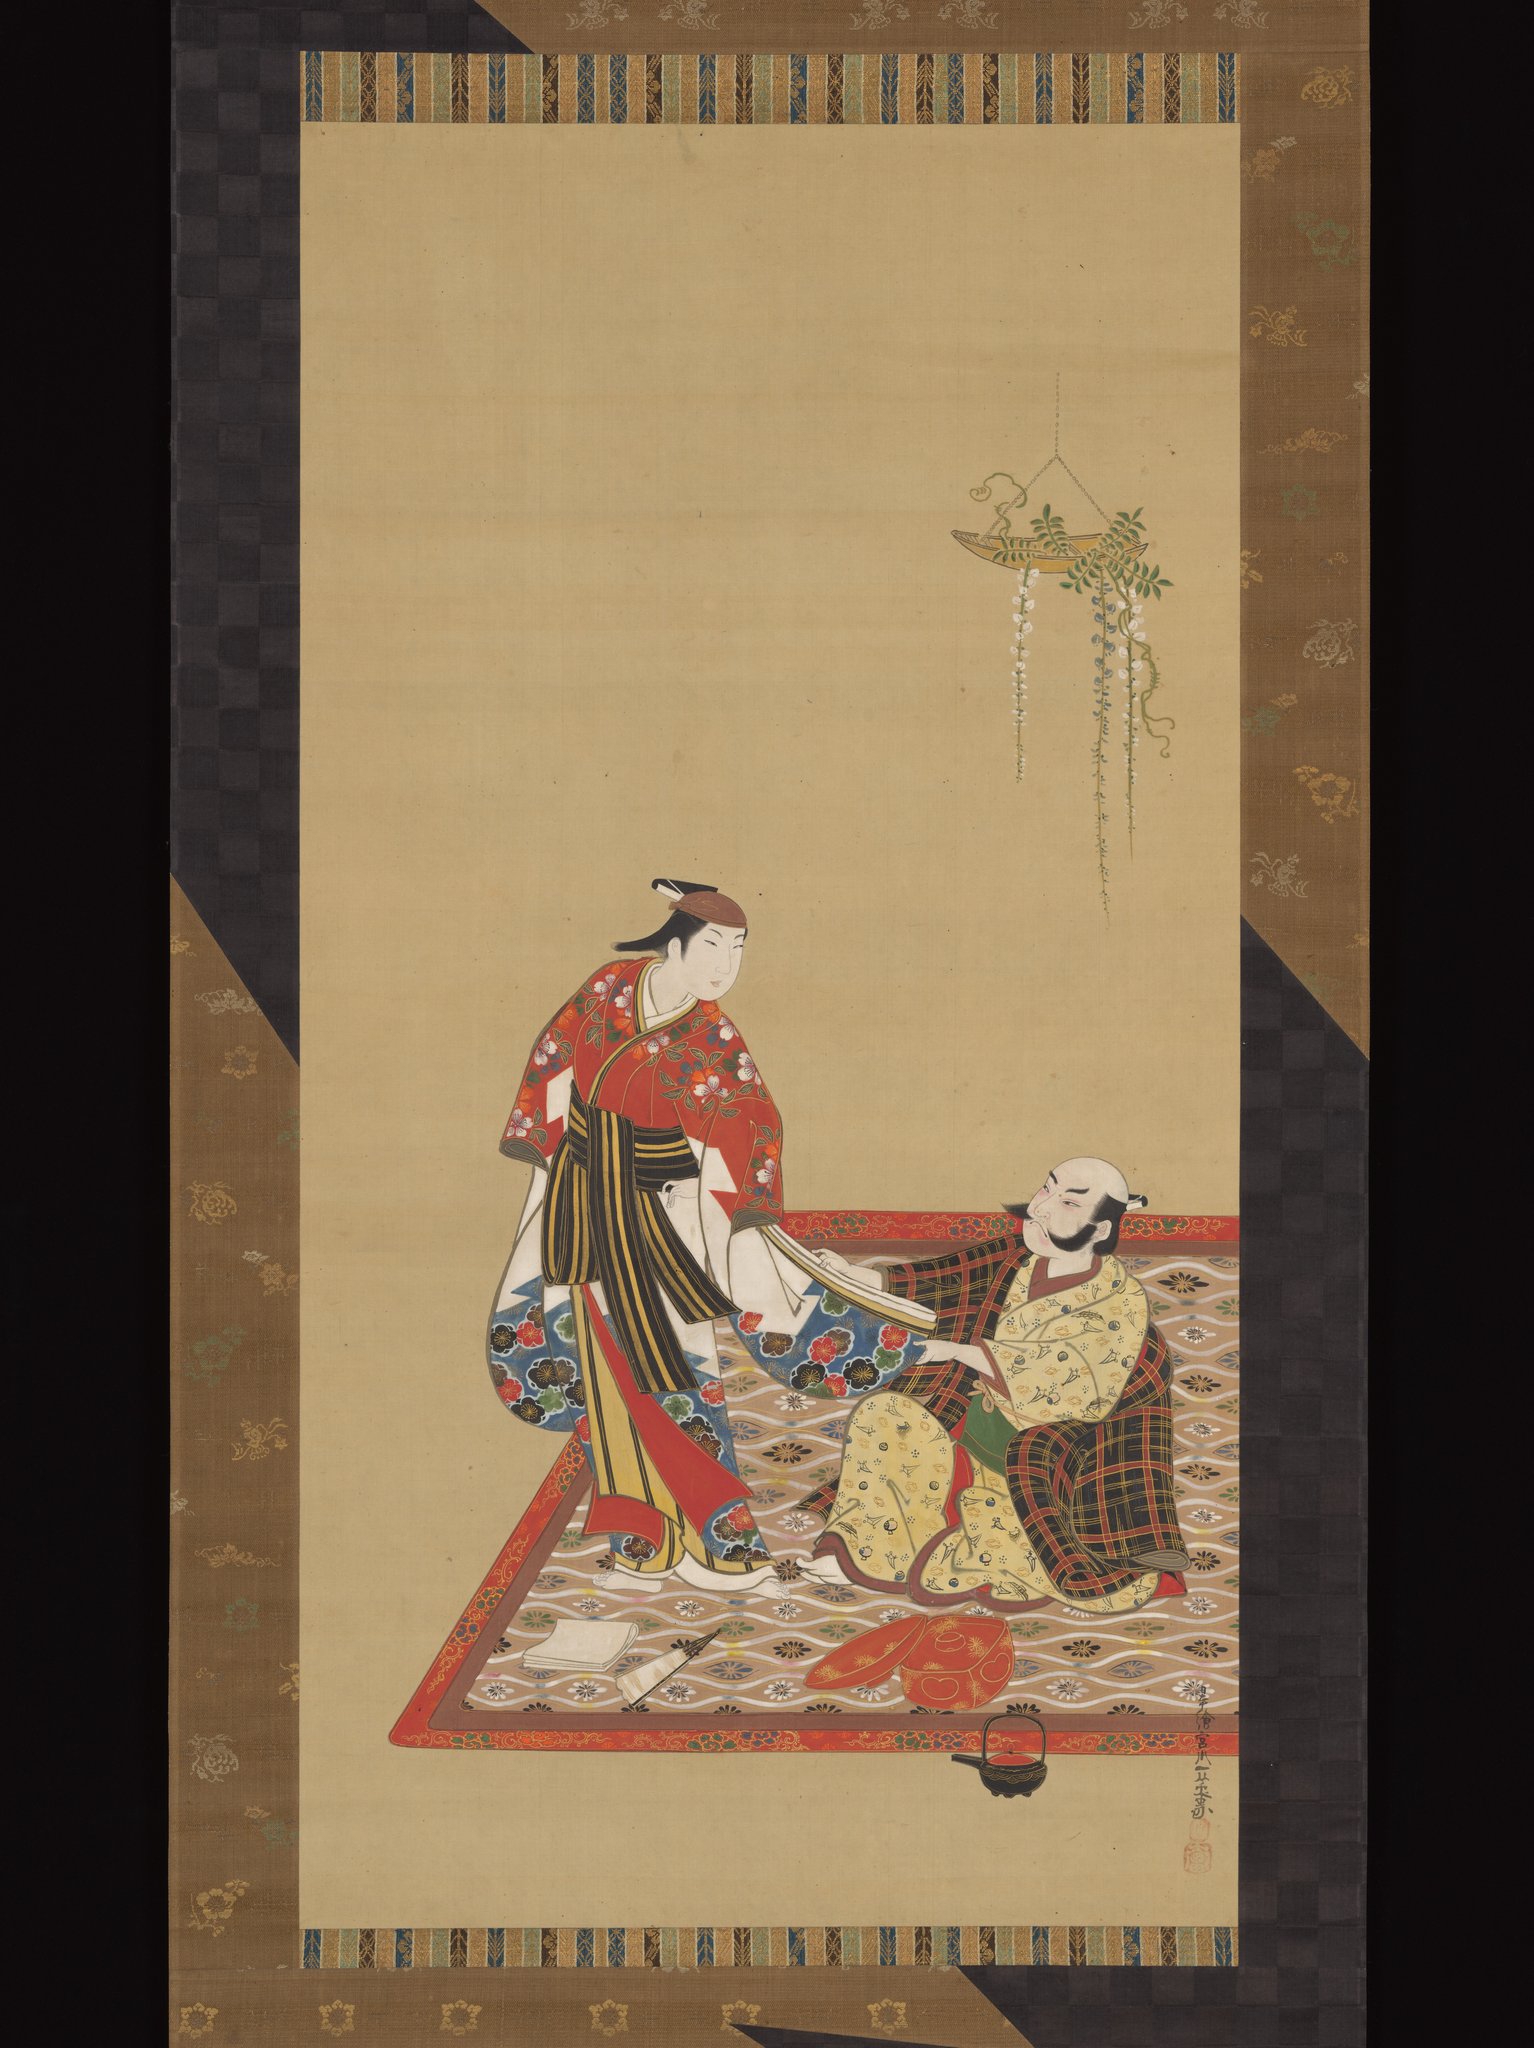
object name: hanging scroll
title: Samurai and Wakashu (Male Youth)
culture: japanese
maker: miyagawa isshō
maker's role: artist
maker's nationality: japanese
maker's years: 1689-1780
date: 1701-1733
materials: ink, silk